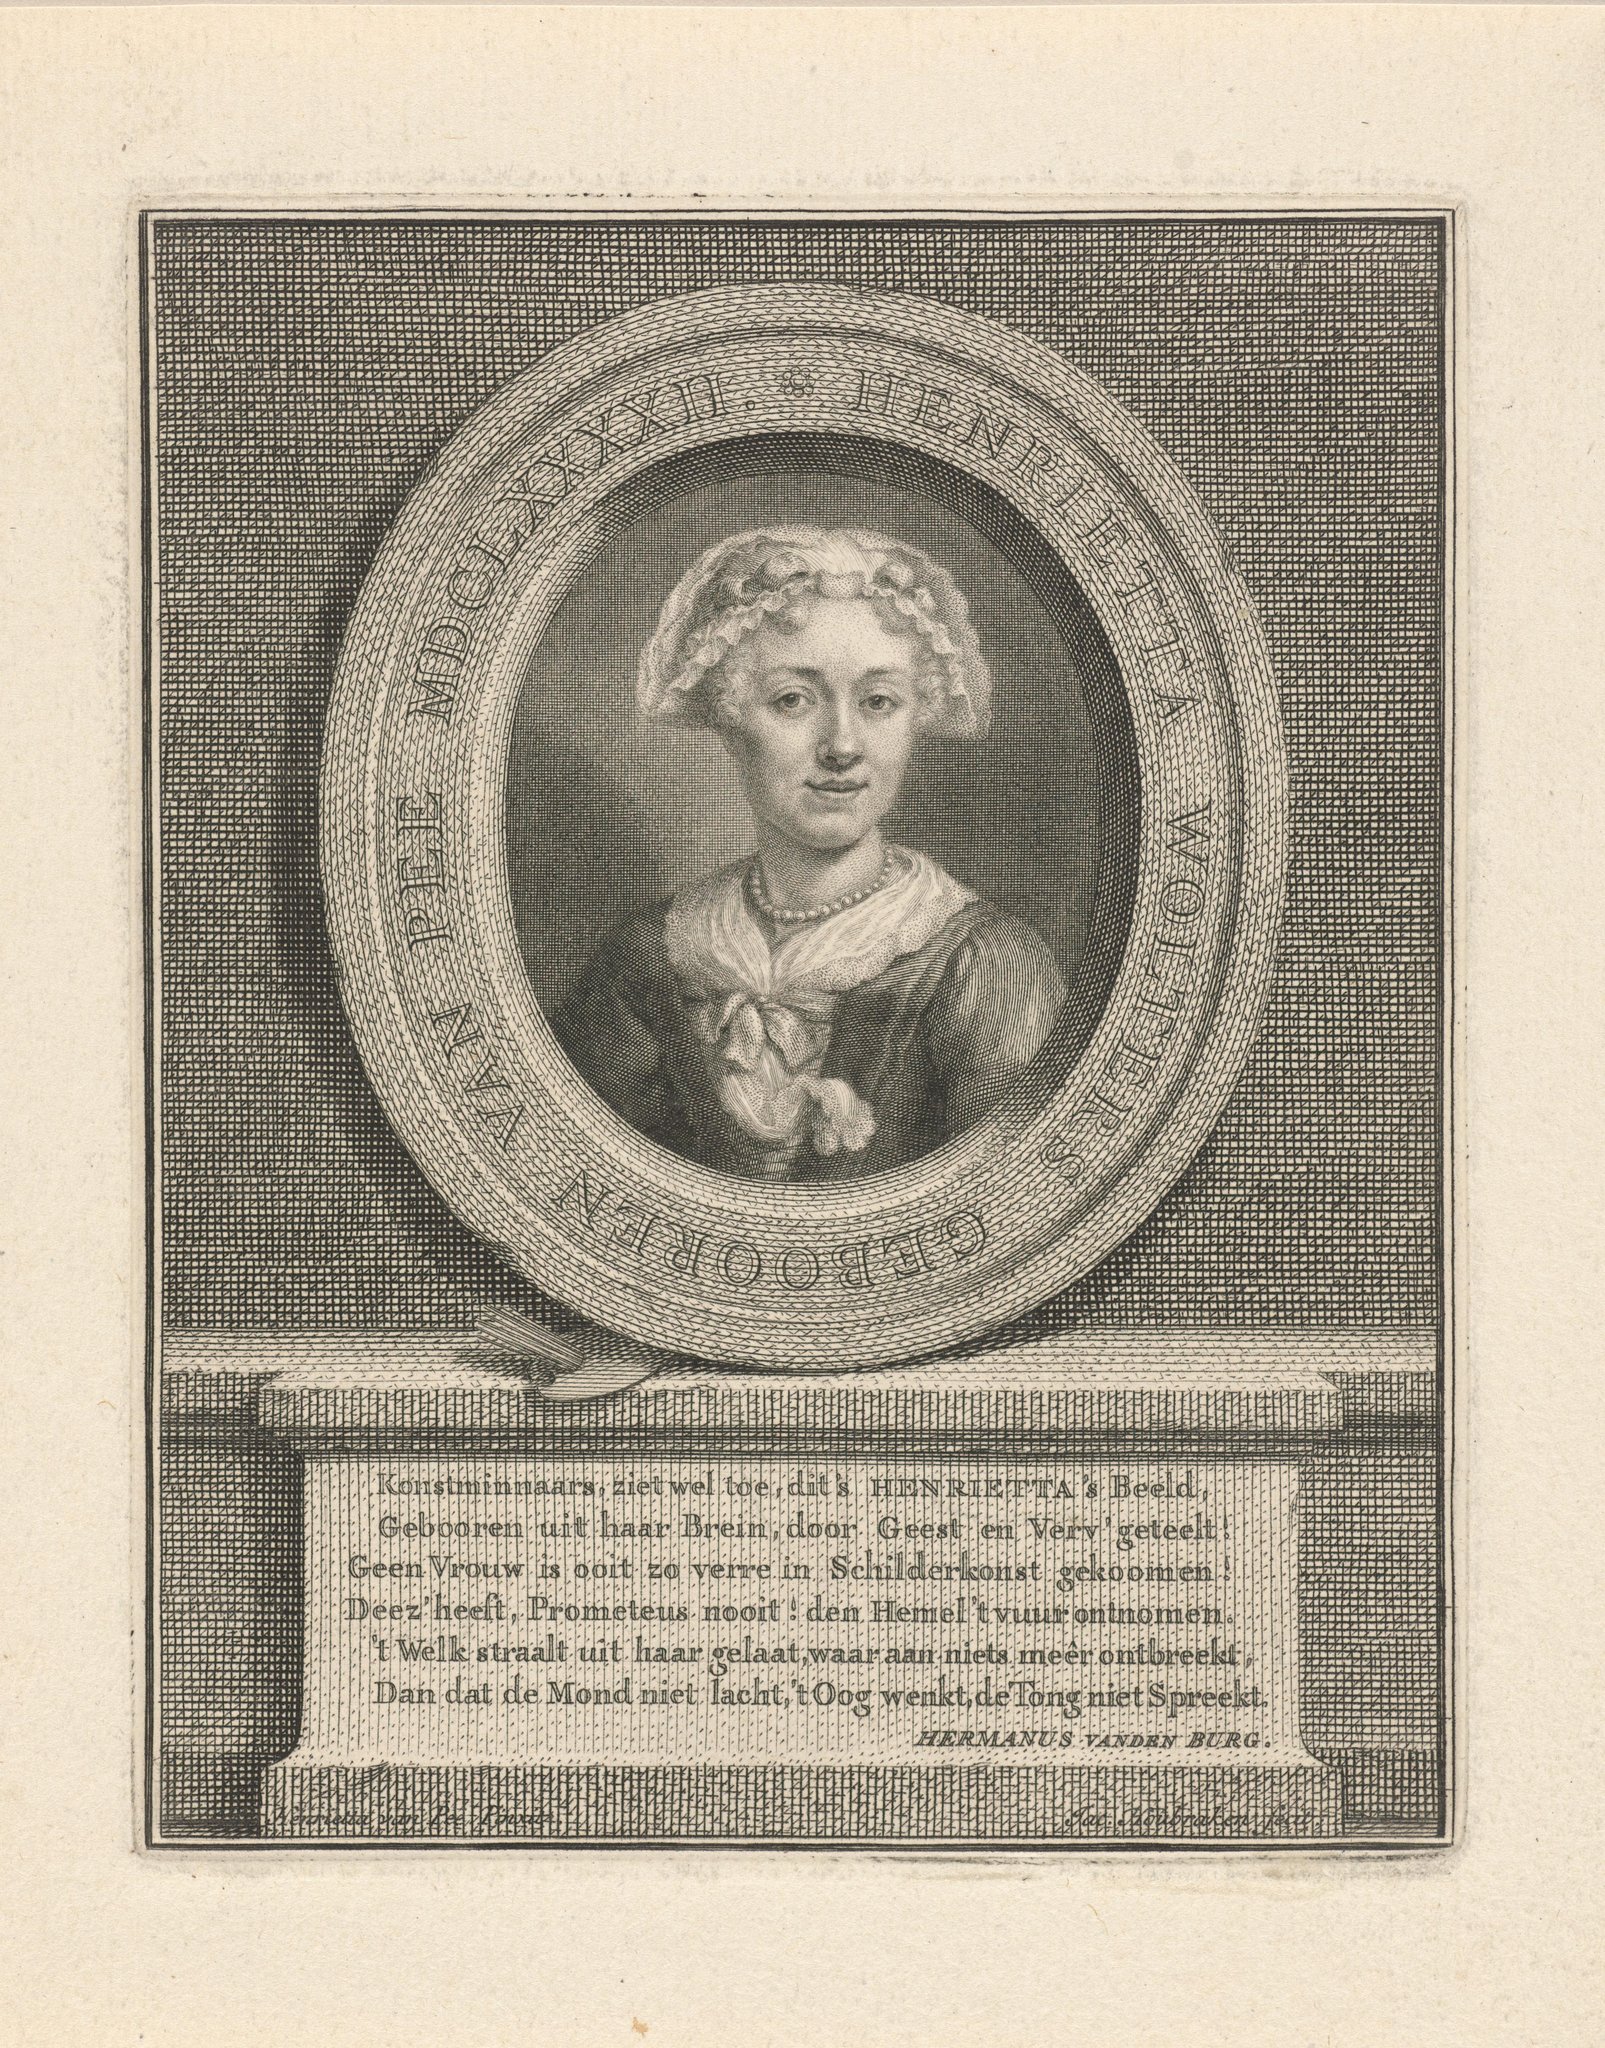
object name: print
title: Portret van Henriëtte Wolters-van Pee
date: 1708-1732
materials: paper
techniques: engraving, etching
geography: amsterdam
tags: henriëtte wolters-van pee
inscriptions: collector's mark: Lugt 240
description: Portret van de miniatuurschilderes Henriëtte Wolters-van Pee, met een zesregelig gedicht.